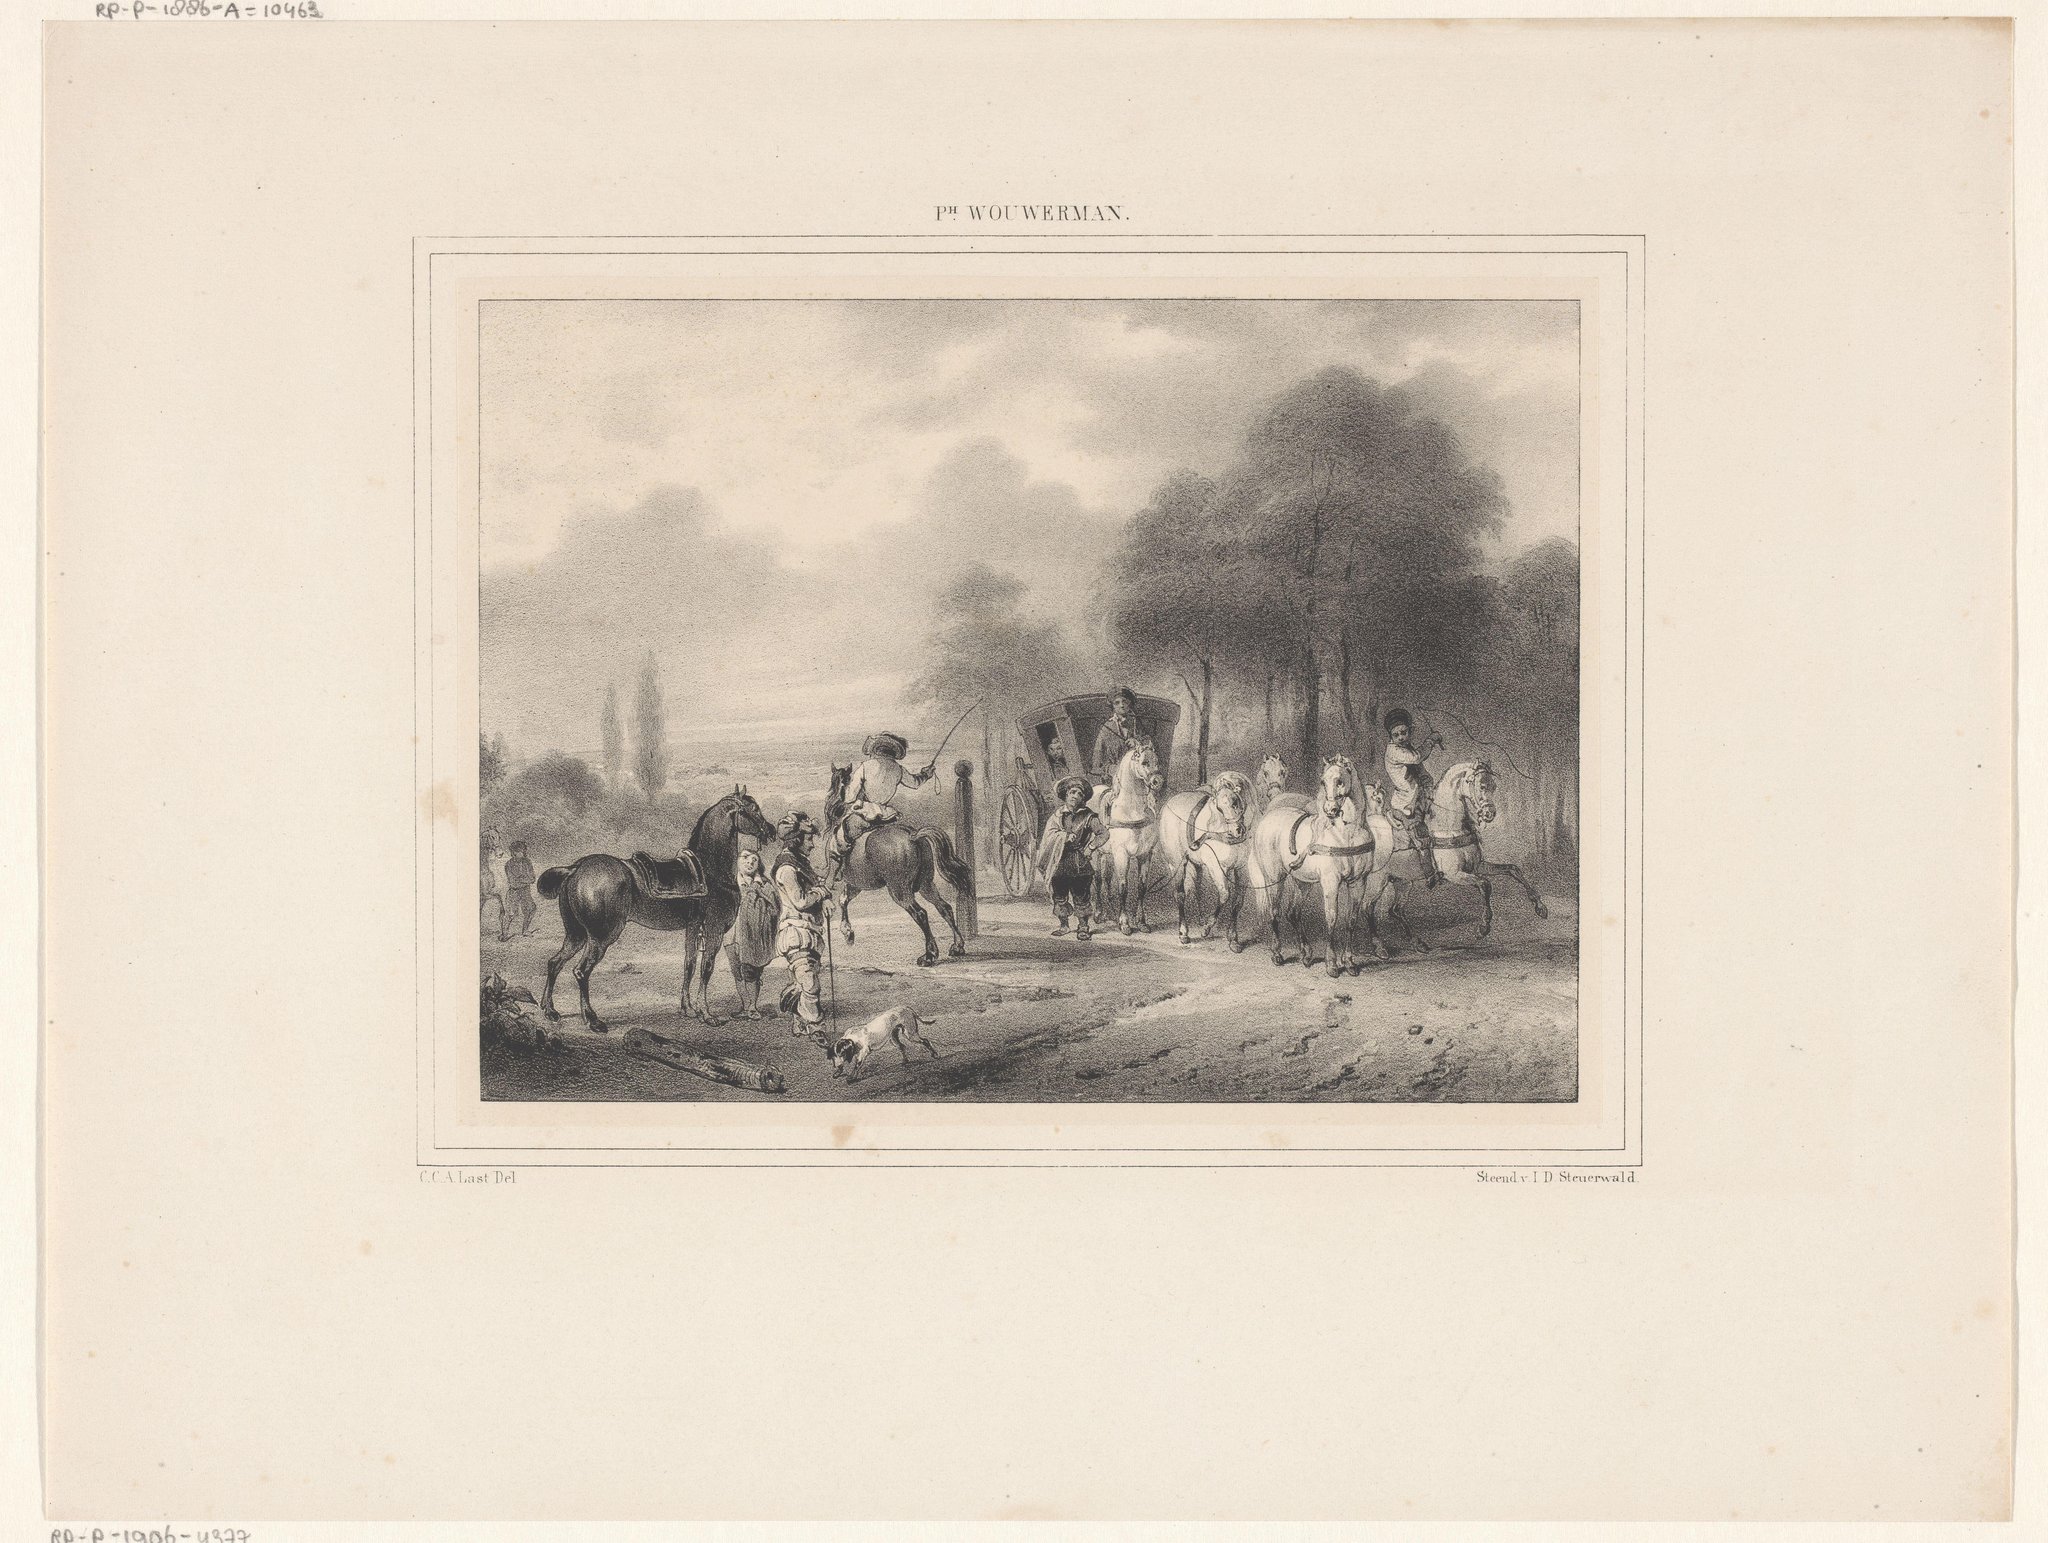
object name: print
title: Rijtuig wordt staande gehouden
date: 1822-1863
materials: paper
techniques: lithograph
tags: traveller(s) attacked by robber(s), two-wheeled vehicle drawn by more than three animals, 'en route', traveller under way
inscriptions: collector's mark: Lugt 2228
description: Twee ruiters met knallende zwepen omcirkelen het rijtuig met zes paarden ervoor. Mogelijk een overval. Links een man bij een paard.